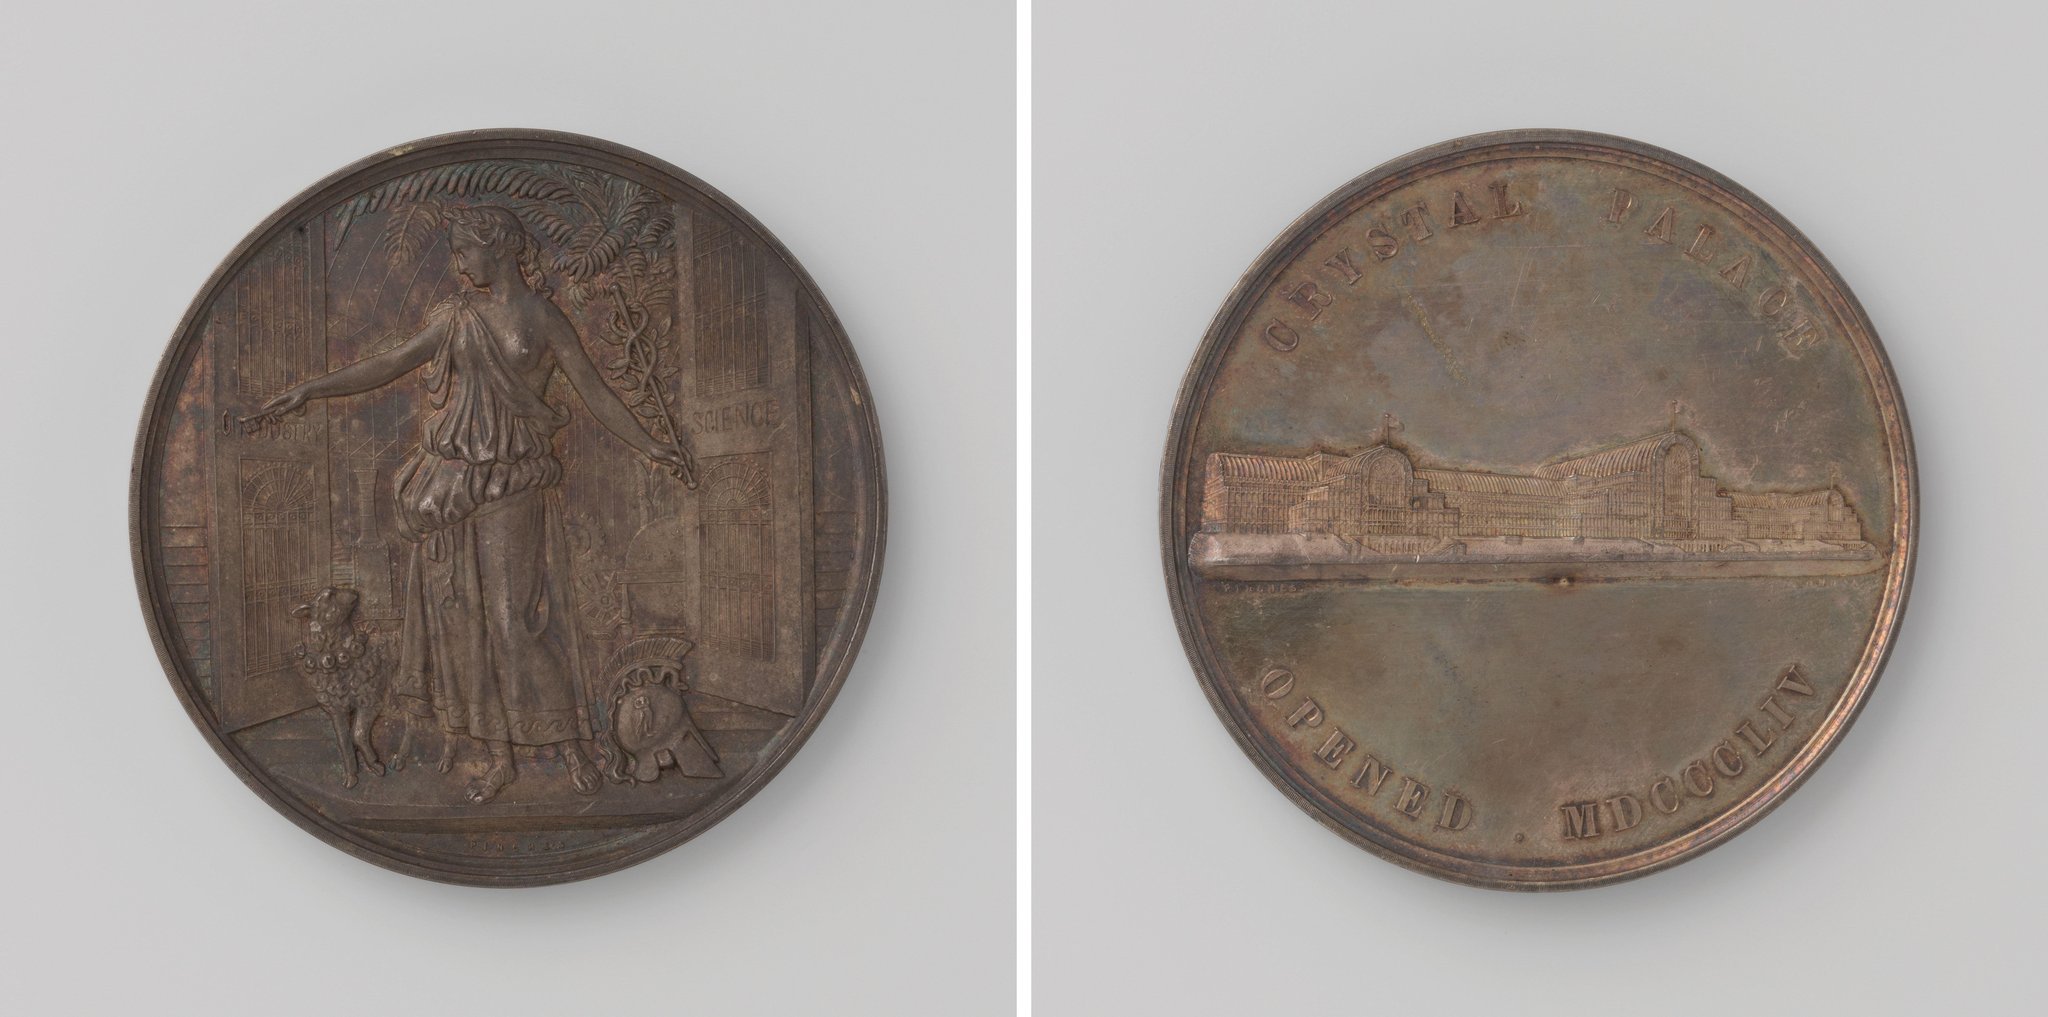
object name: history medal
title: Opening van de internationale tentoonstelling van industrie in het Crystal Palace te Londen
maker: john pinches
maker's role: medailleur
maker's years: 1846-1905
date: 1854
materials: silver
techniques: striking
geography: london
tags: crystal palace, wereldtentoonstelling 1851 (londen)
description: Zilveren penning. Voorzijde: vrouw met lauwerkrans op hoofd opent met sleutel in haar rechterhand toegangsdeuren tot expositie; links een lam met krans om nek, rechts een helm. Keerzijde: tentoonstellingsgebouw binnen omschrift.